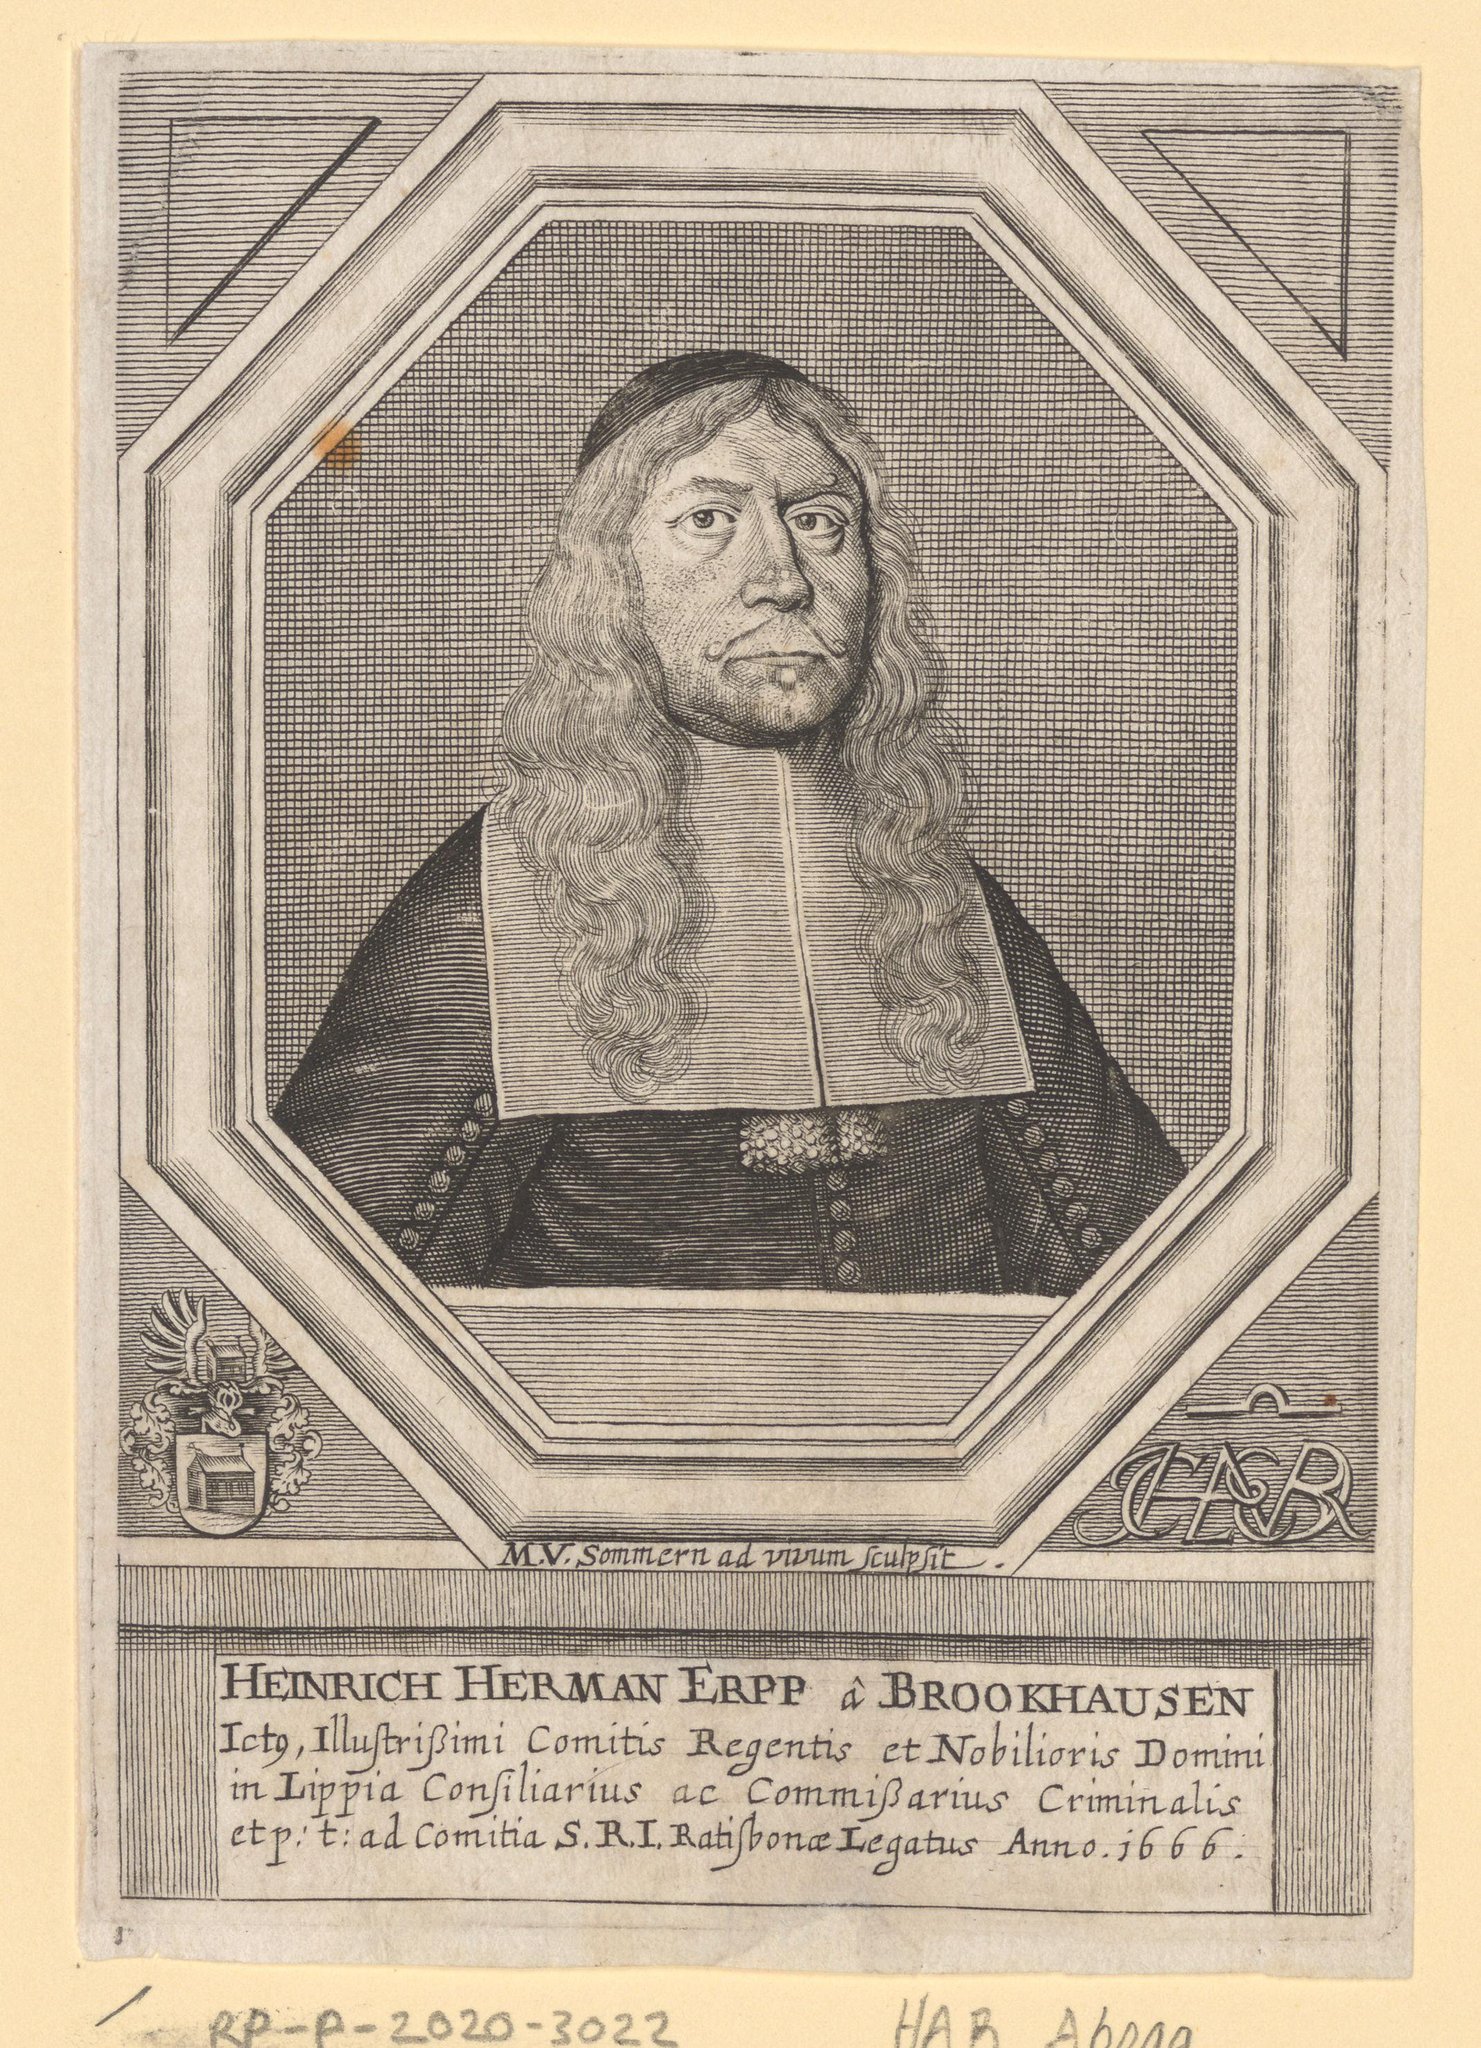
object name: print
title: Portret van Heinrich Herman Erpp von Brockhausen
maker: matthias van sommer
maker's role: draughtsman, print maker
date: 1666-1667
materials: paper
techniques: engraving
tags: historical persons, armorial bearing, heraldry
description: Prent waarschijnlijk uit: [Somer, Matthias van]. Hasce omnium electorum principum ac statuum Sacri Romani Imperii ad comitia praesentia legatis ac deputatis icones (…). Regensburg: [Matthias van Somer], 1667.